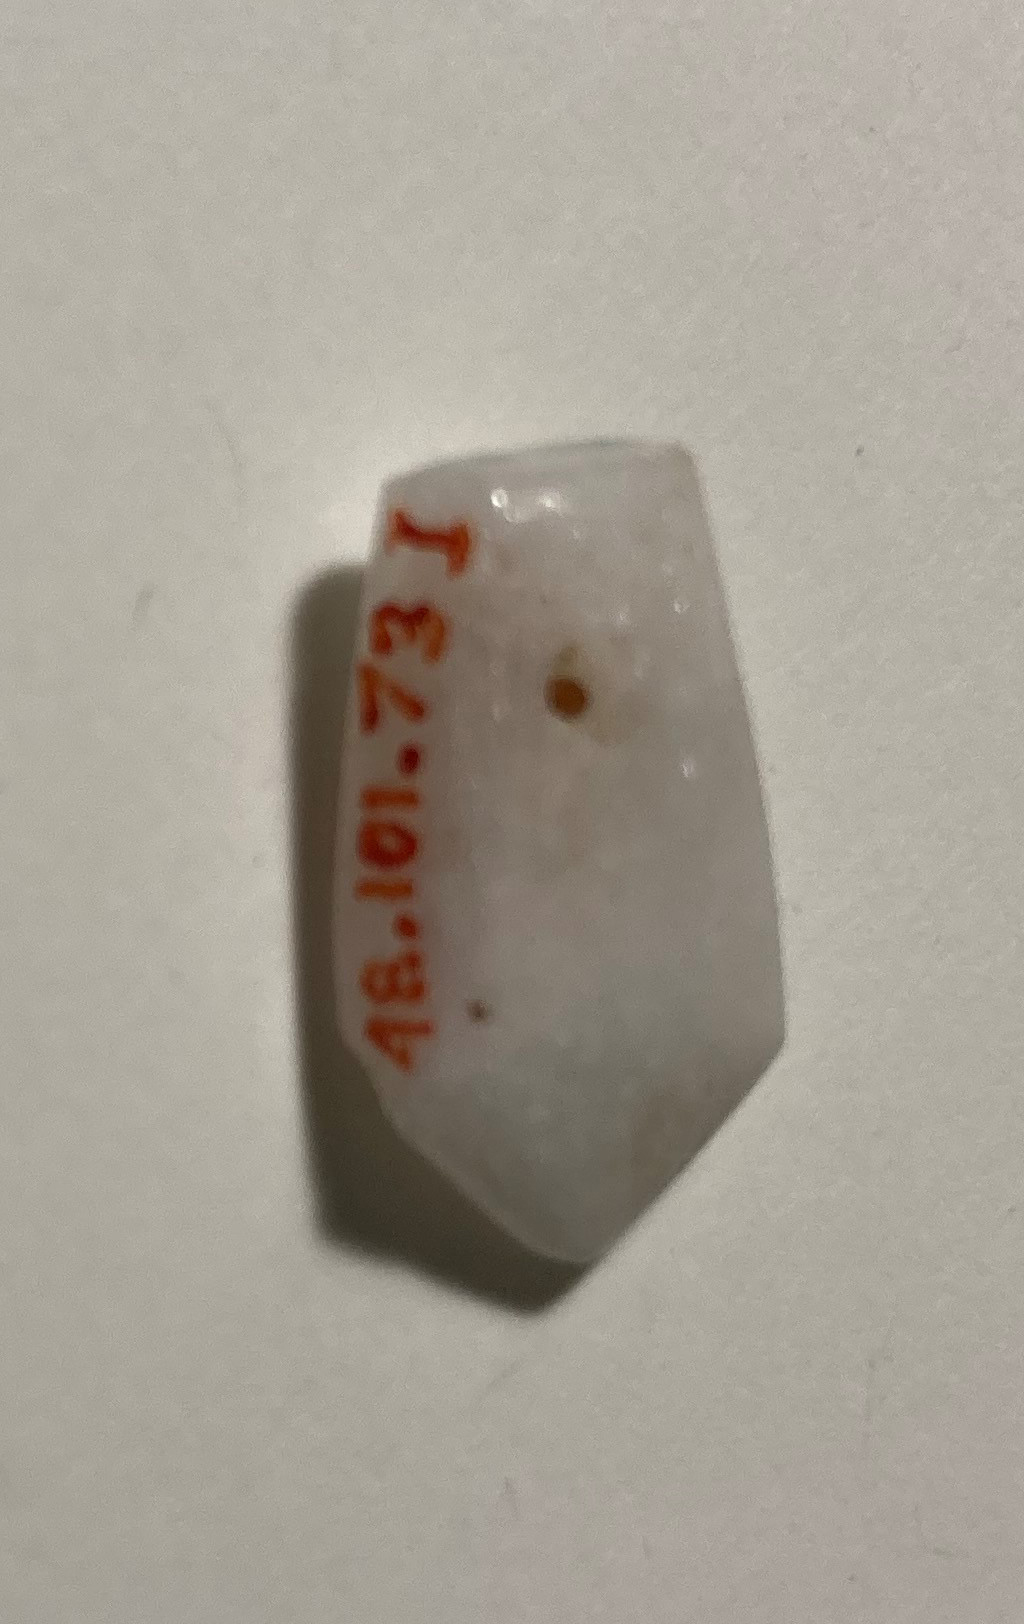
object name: bead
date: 701-1200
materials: stone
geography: iran